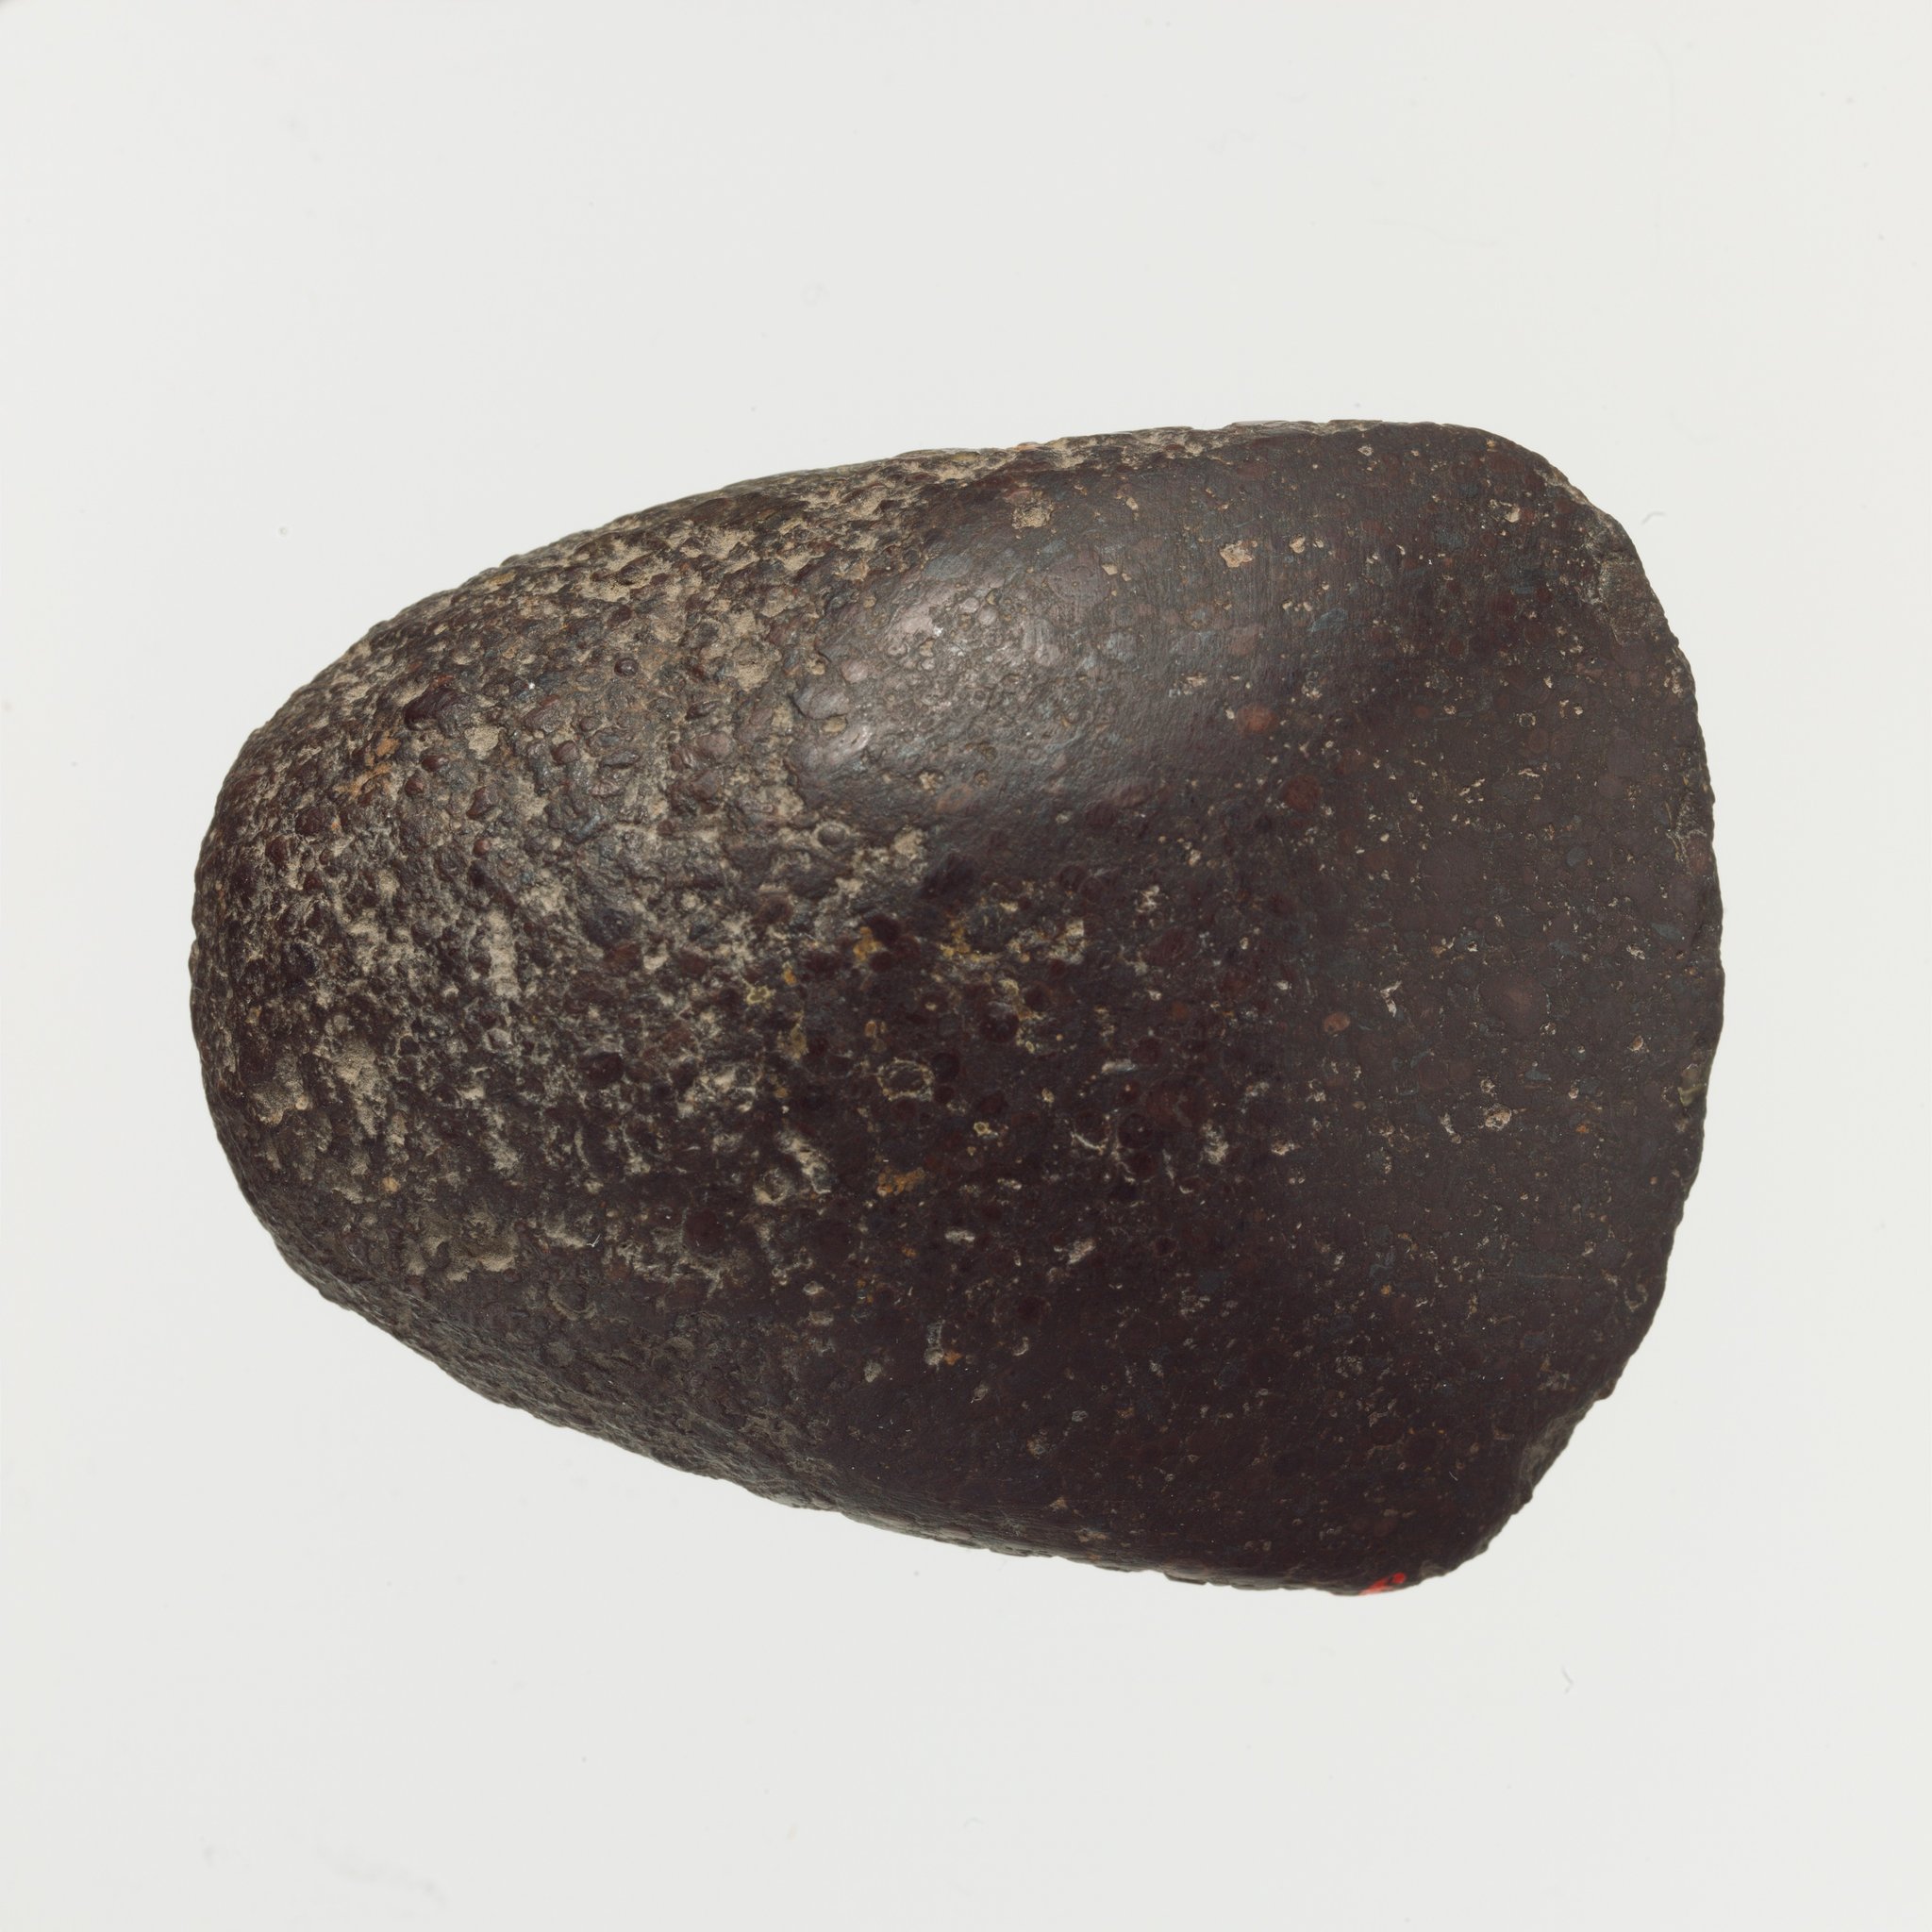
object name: celt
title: Small pisolitic bauxite axe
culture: cretan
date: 5000-3001 BCE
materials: stone